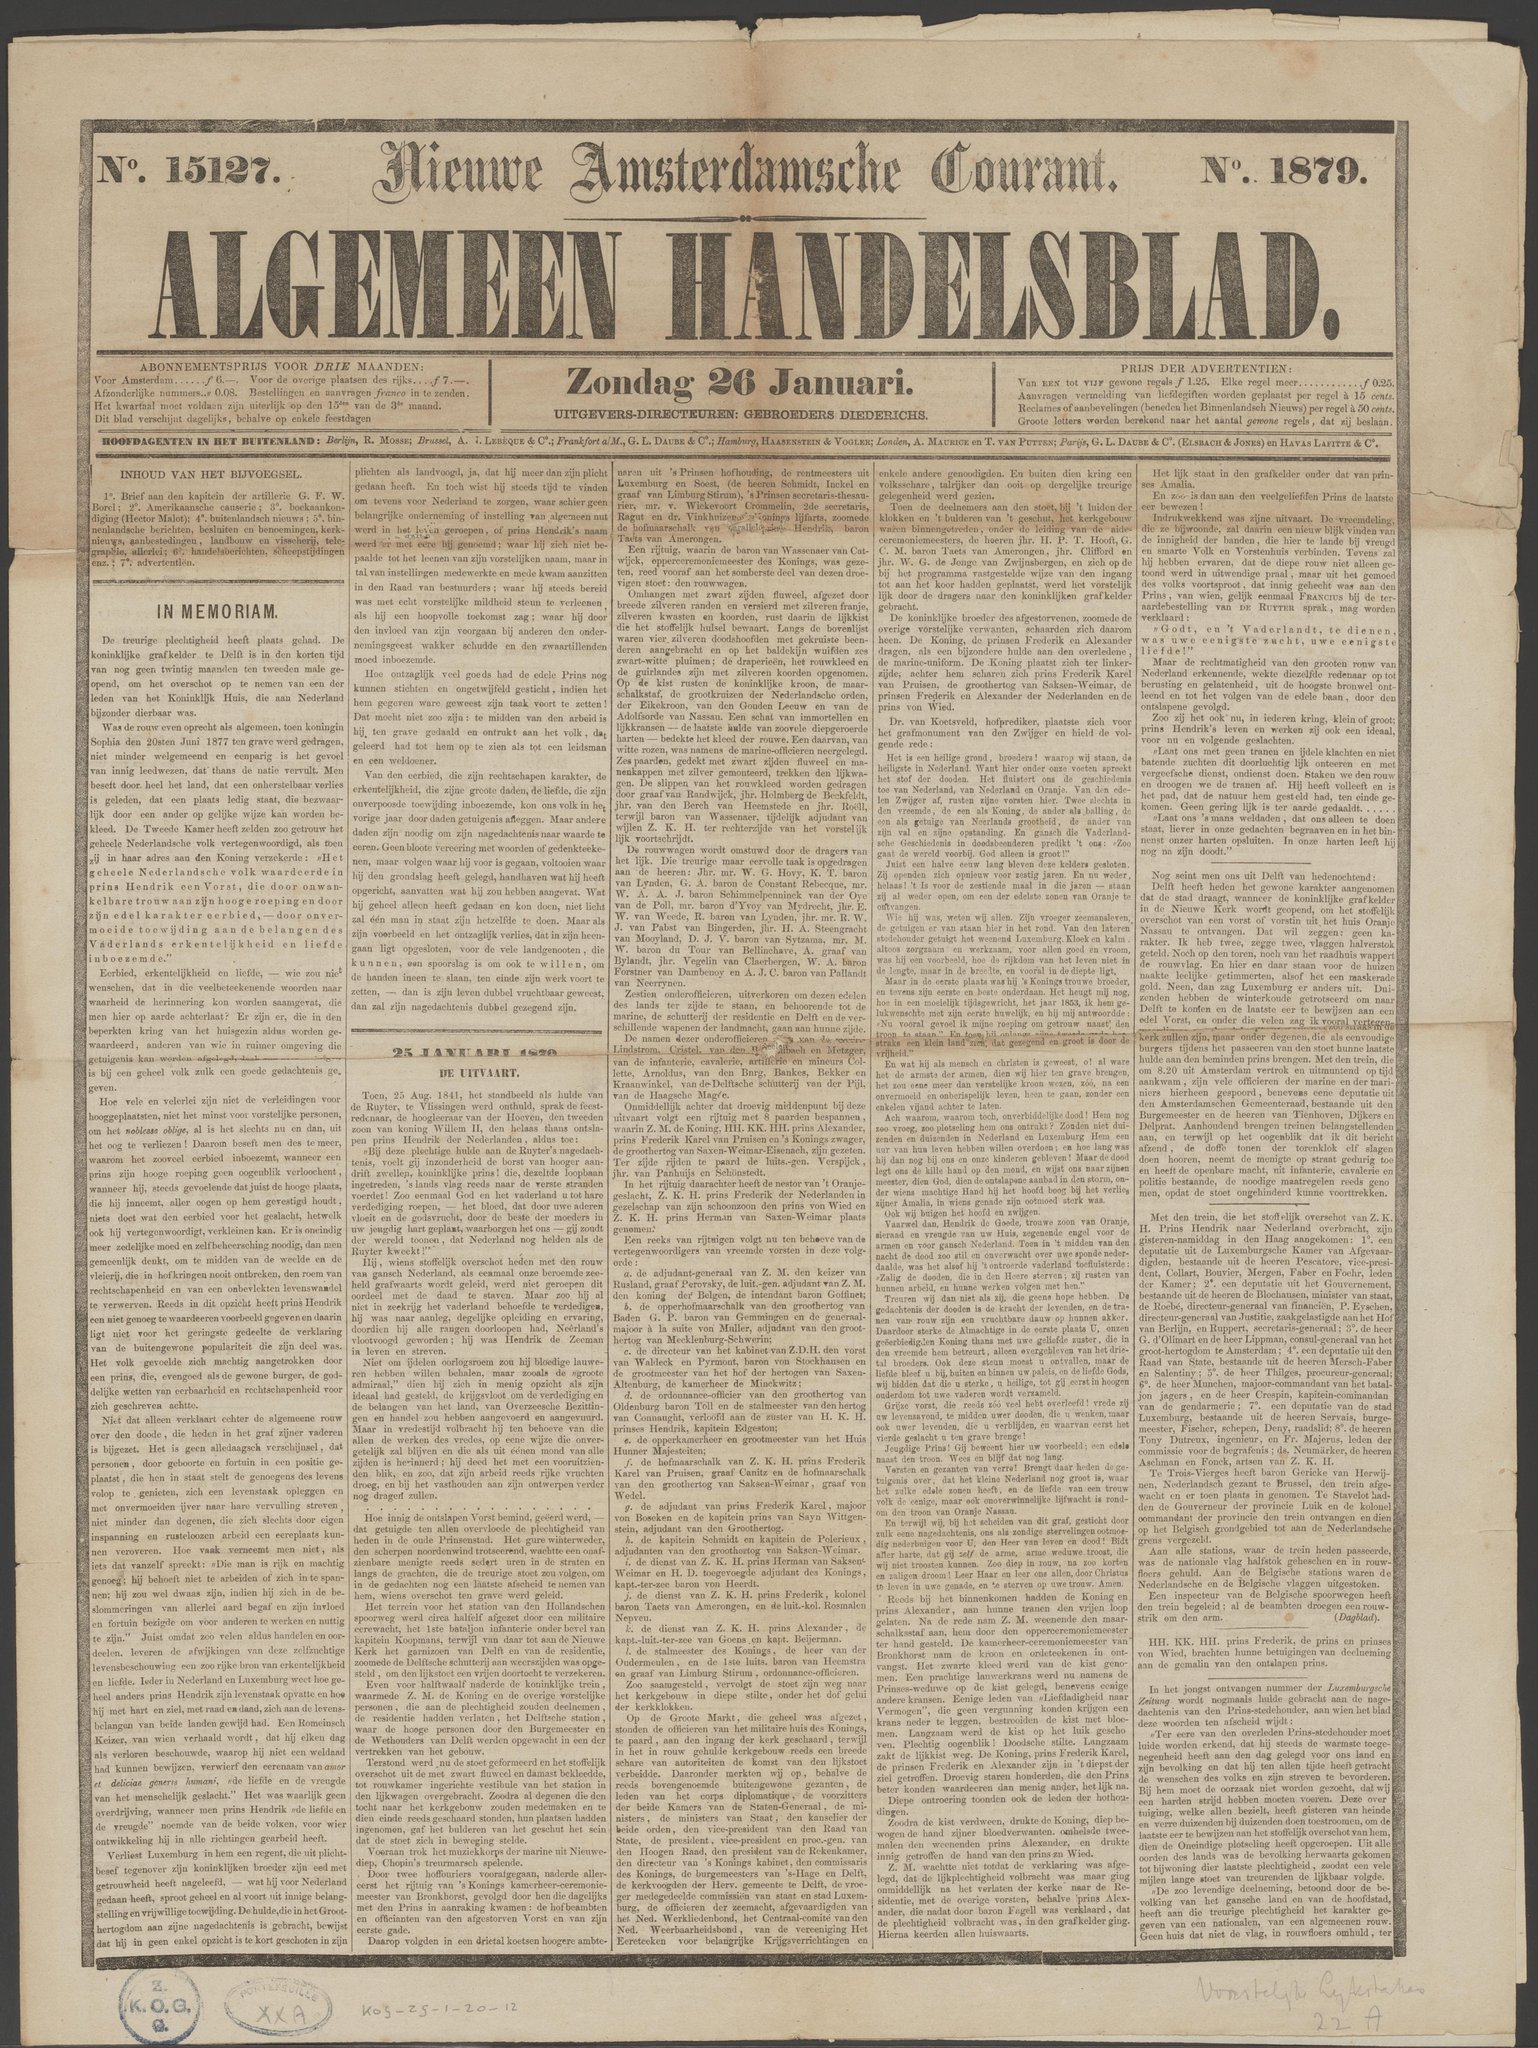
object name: newspaper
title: Bijvoegsel van het Algemeen Handelsblad over het overlijden van Hendrik, prins der Nederlanden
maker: Anonymous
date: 1879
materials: paper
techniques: letterpress printing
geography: amsterdam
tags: hendrik (prins der nederlanden), burial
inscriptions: stamp, collector's mark: Lugt 1641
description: Linksboven genummerd: No. 15127. Onderwerpsrubrieken binnen de Atlas Zeden en Gewoonten: Zeden en Gewoonten in Engeren Zin, Des menschen beging, midden en einde, Vorstelijke lijkstaties.